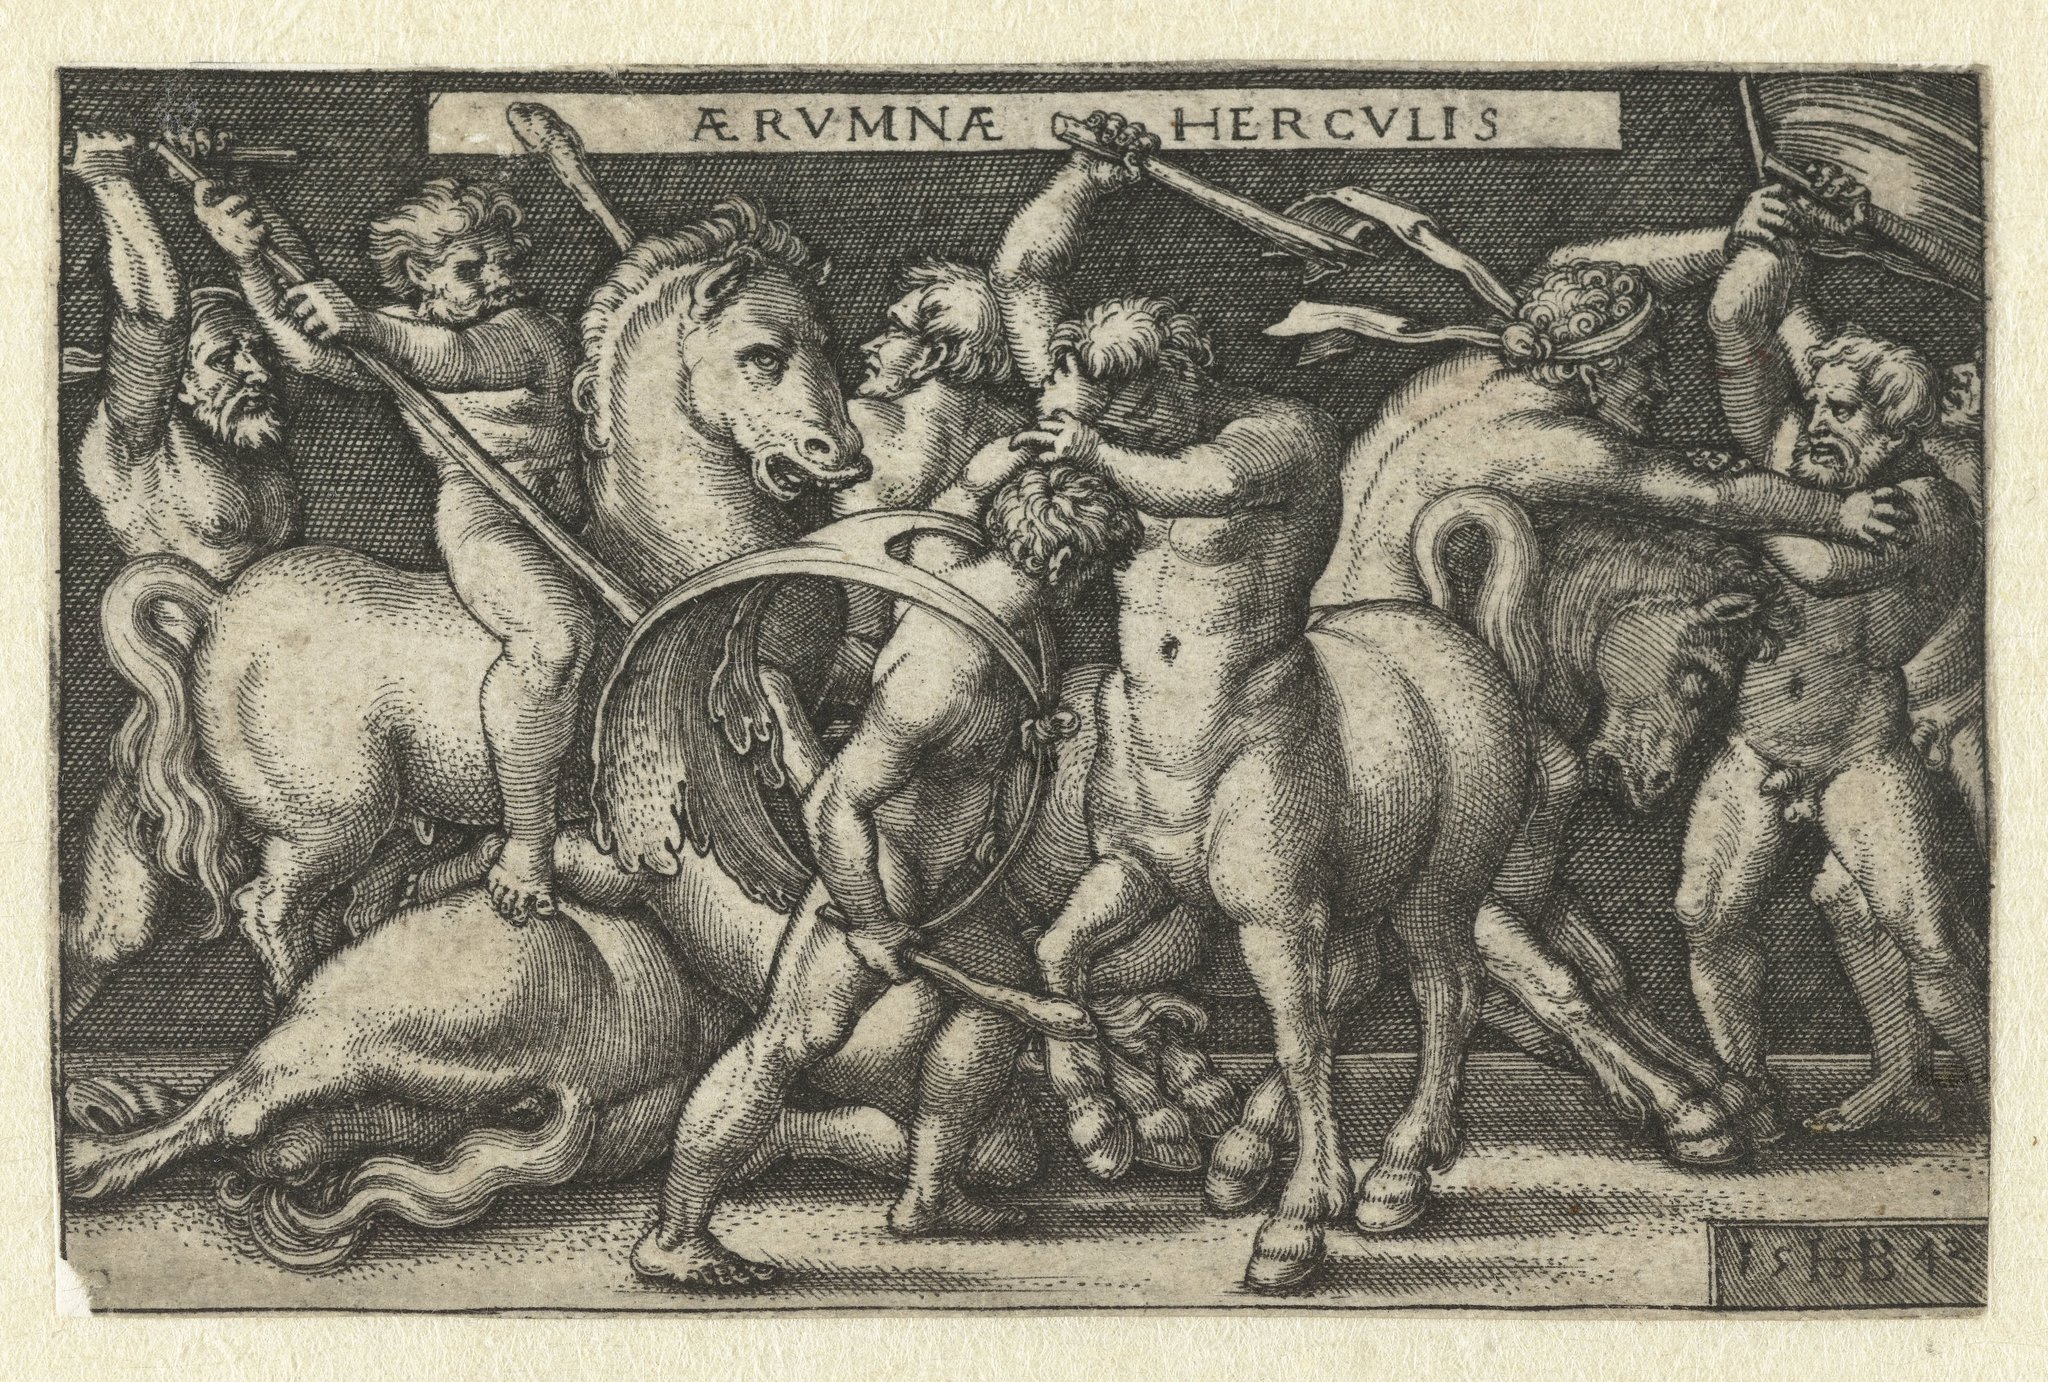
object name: print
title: Werken van Hercules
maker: hans sebald beham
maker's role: designer, draughtsman, print maker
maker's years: 1500-1550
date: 1542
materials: paper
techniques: engraving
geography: frankfurt am main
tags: most important deeds of hercules: the twelve labours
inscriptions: collector's mark: Lugt 11